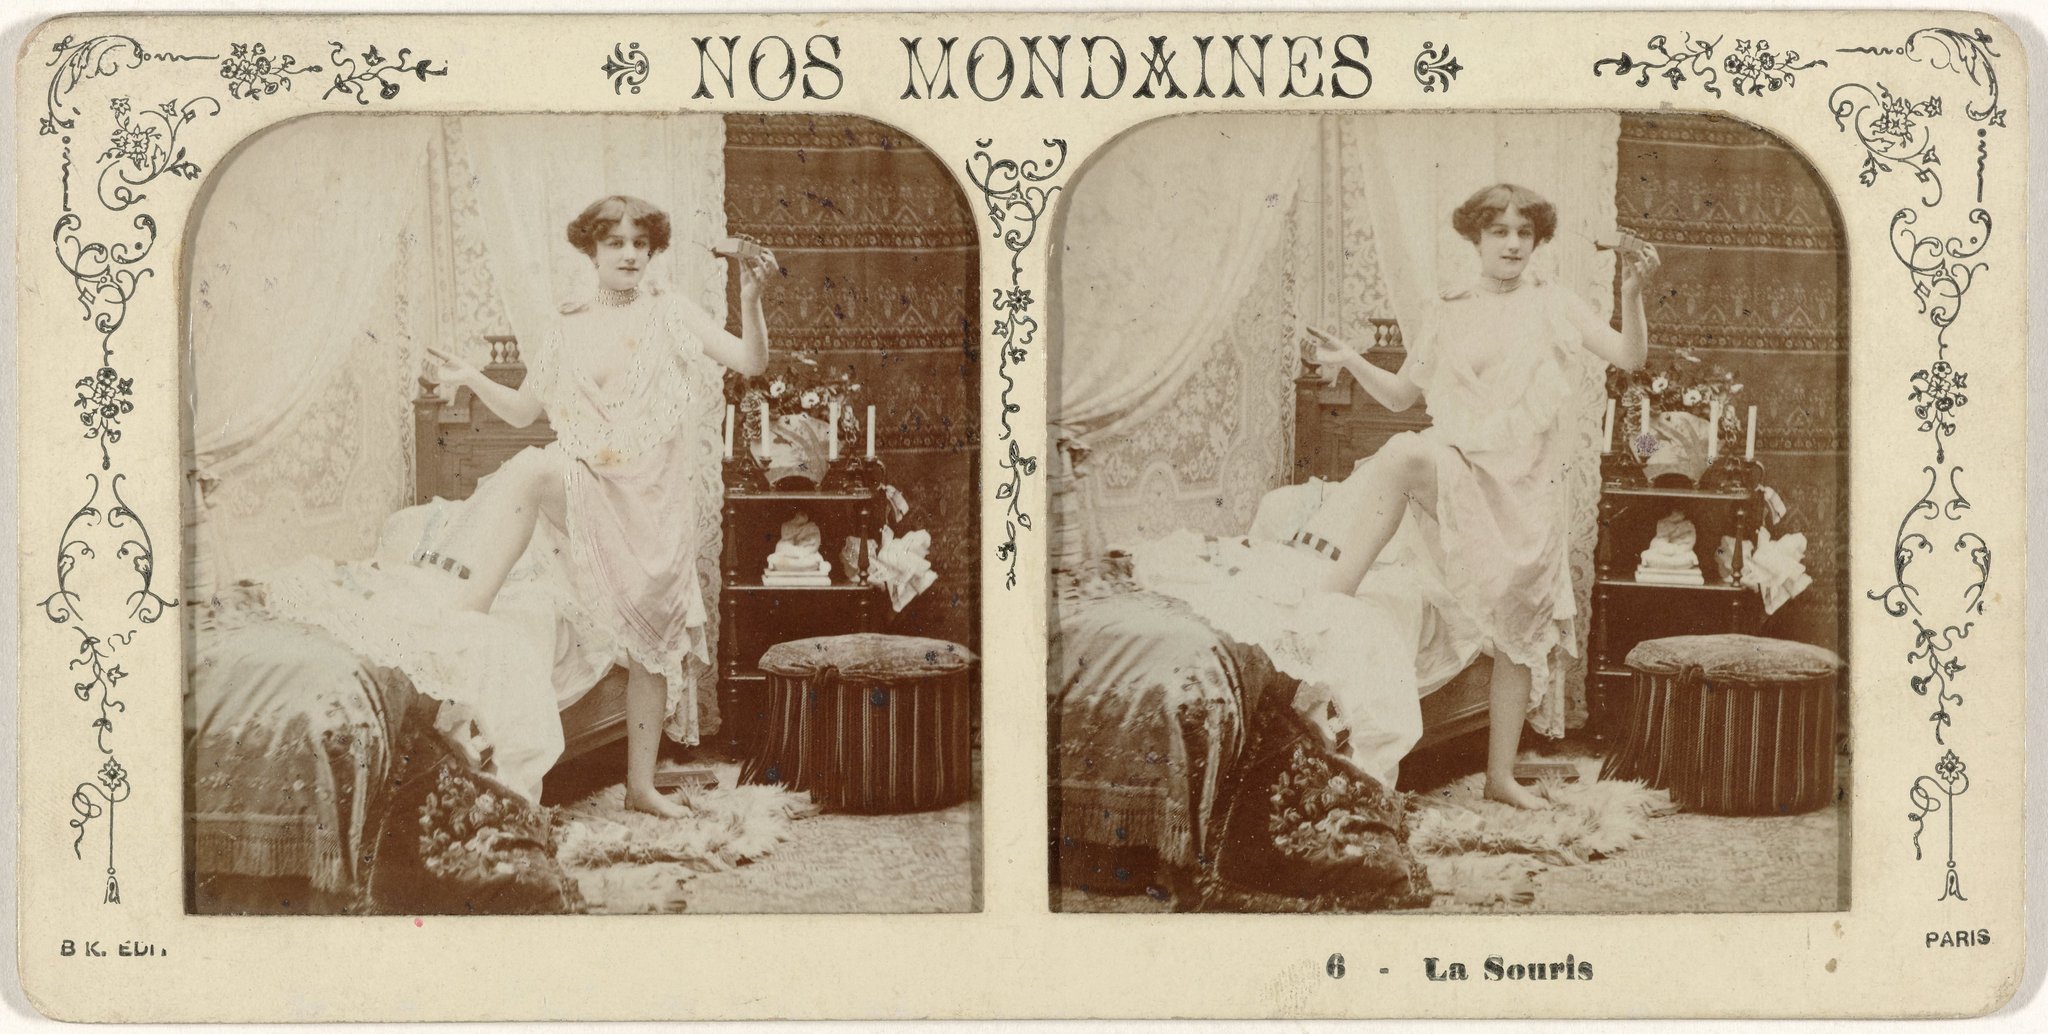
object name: tissue stereograph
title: Vrouw poseert met een muizenval in de hand naast een bed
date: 1863-1875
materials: cardboard, paper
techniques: albumen print, hand coloring, perforating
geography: france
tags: adult woman, mouse trap, bedroom, france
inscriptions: number: ‘6’